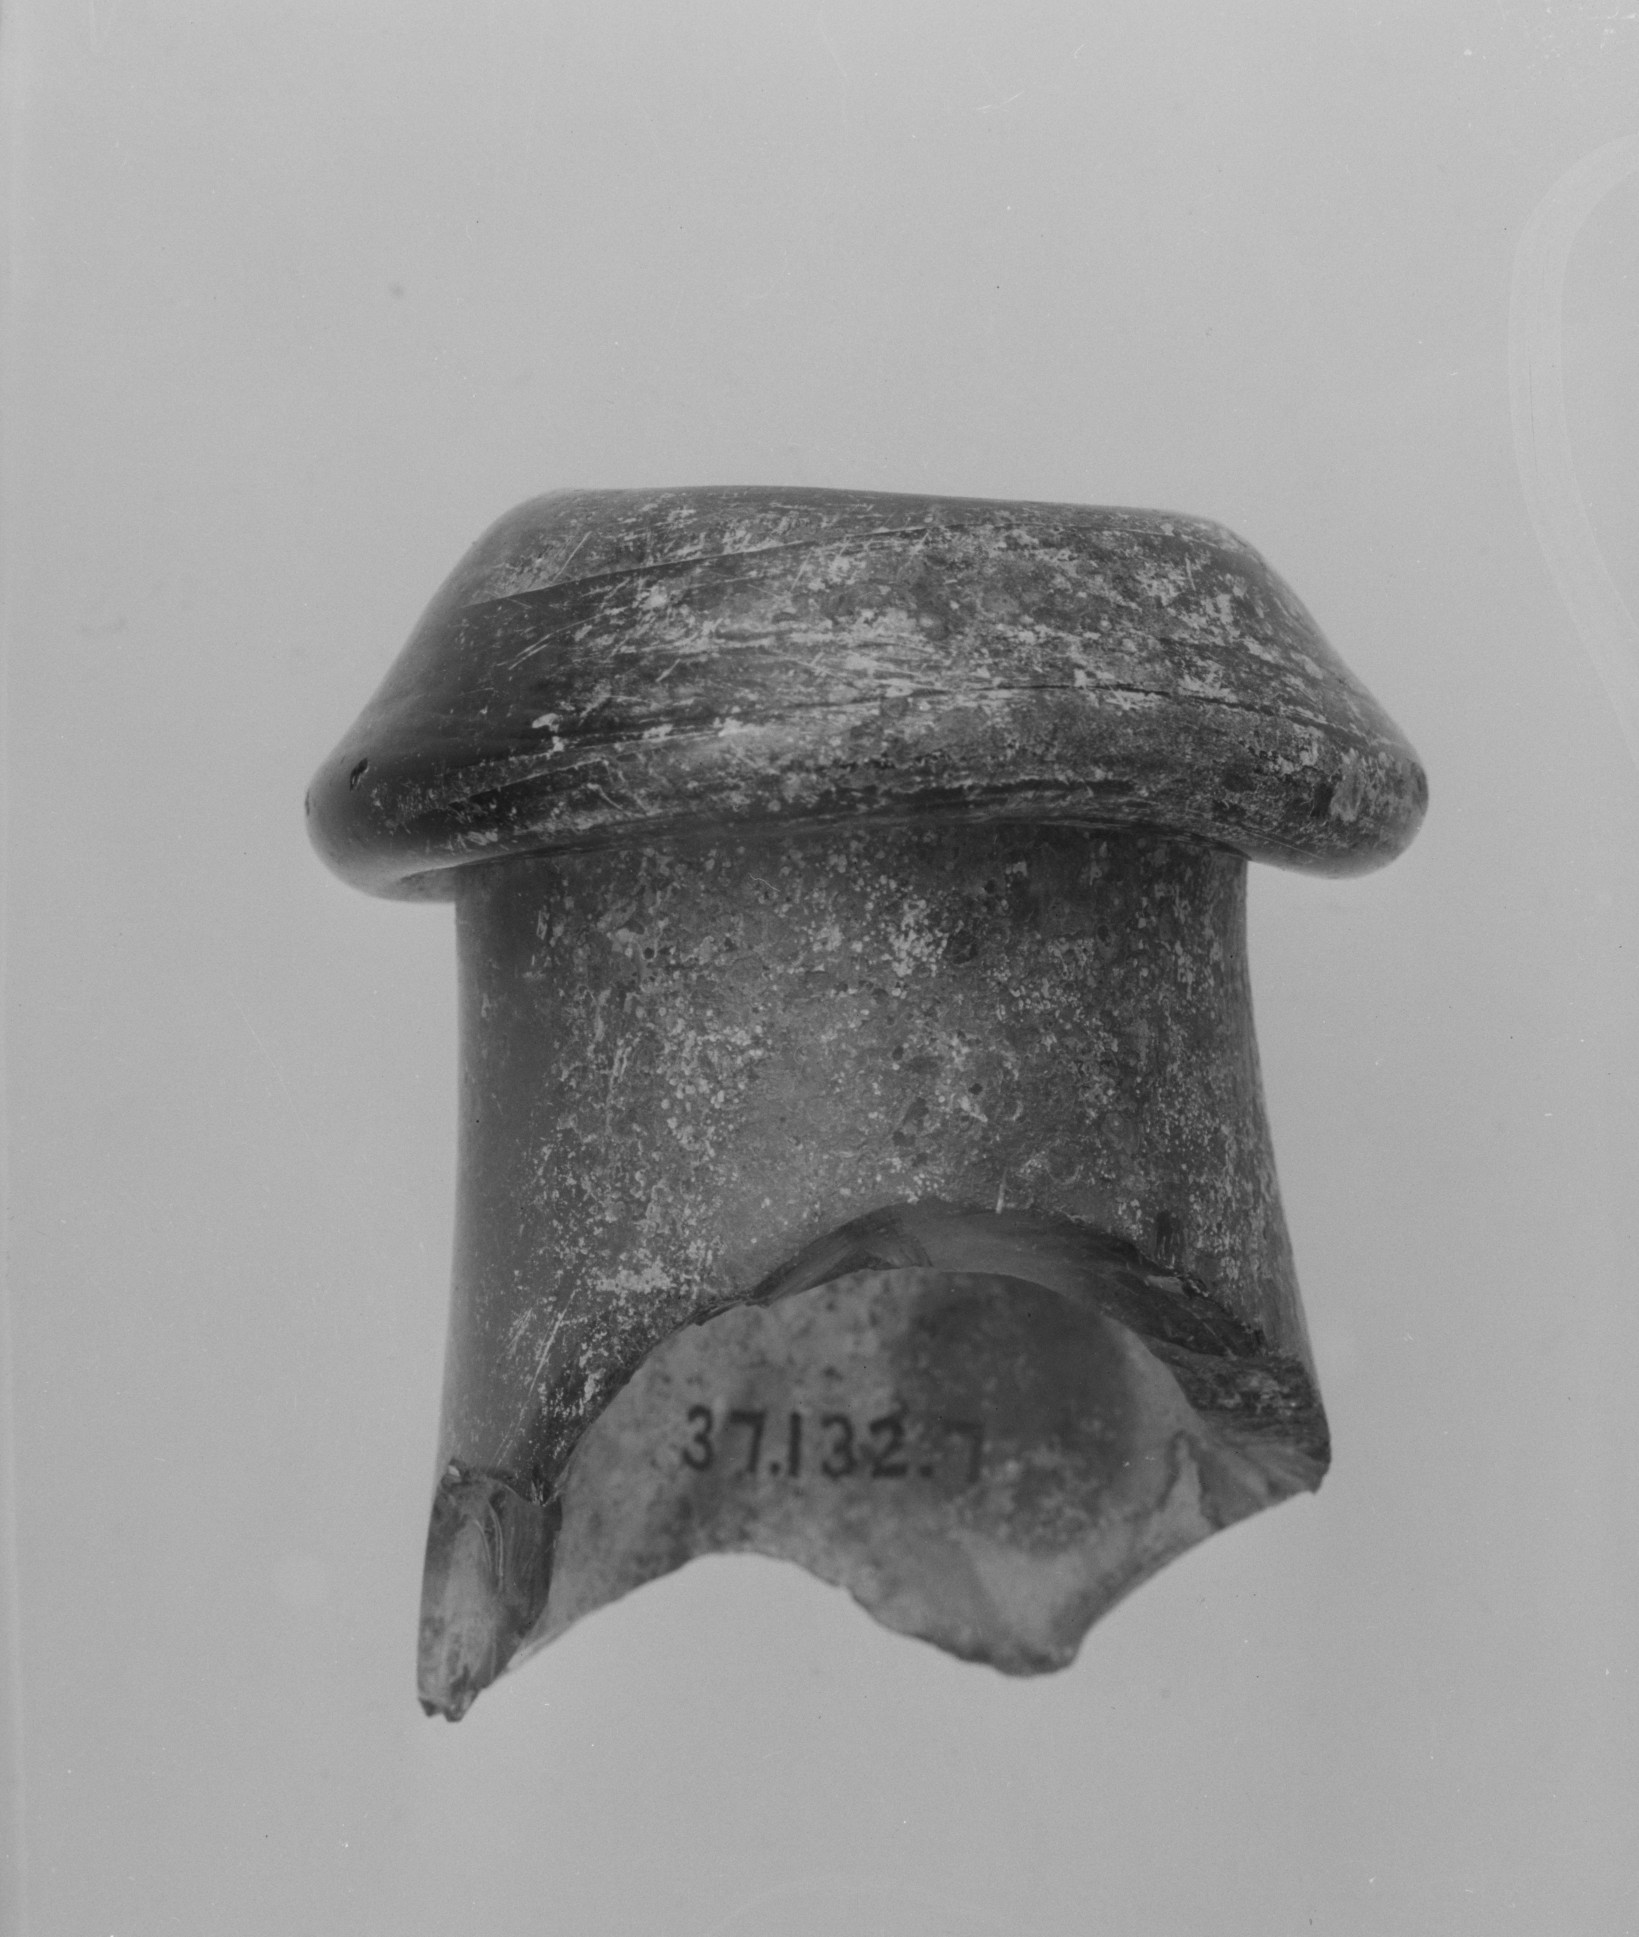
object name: bottle fragment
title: Fragment of a Bottle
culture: american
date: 1701-1800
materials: glass, lead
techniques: glassblowing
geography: united states